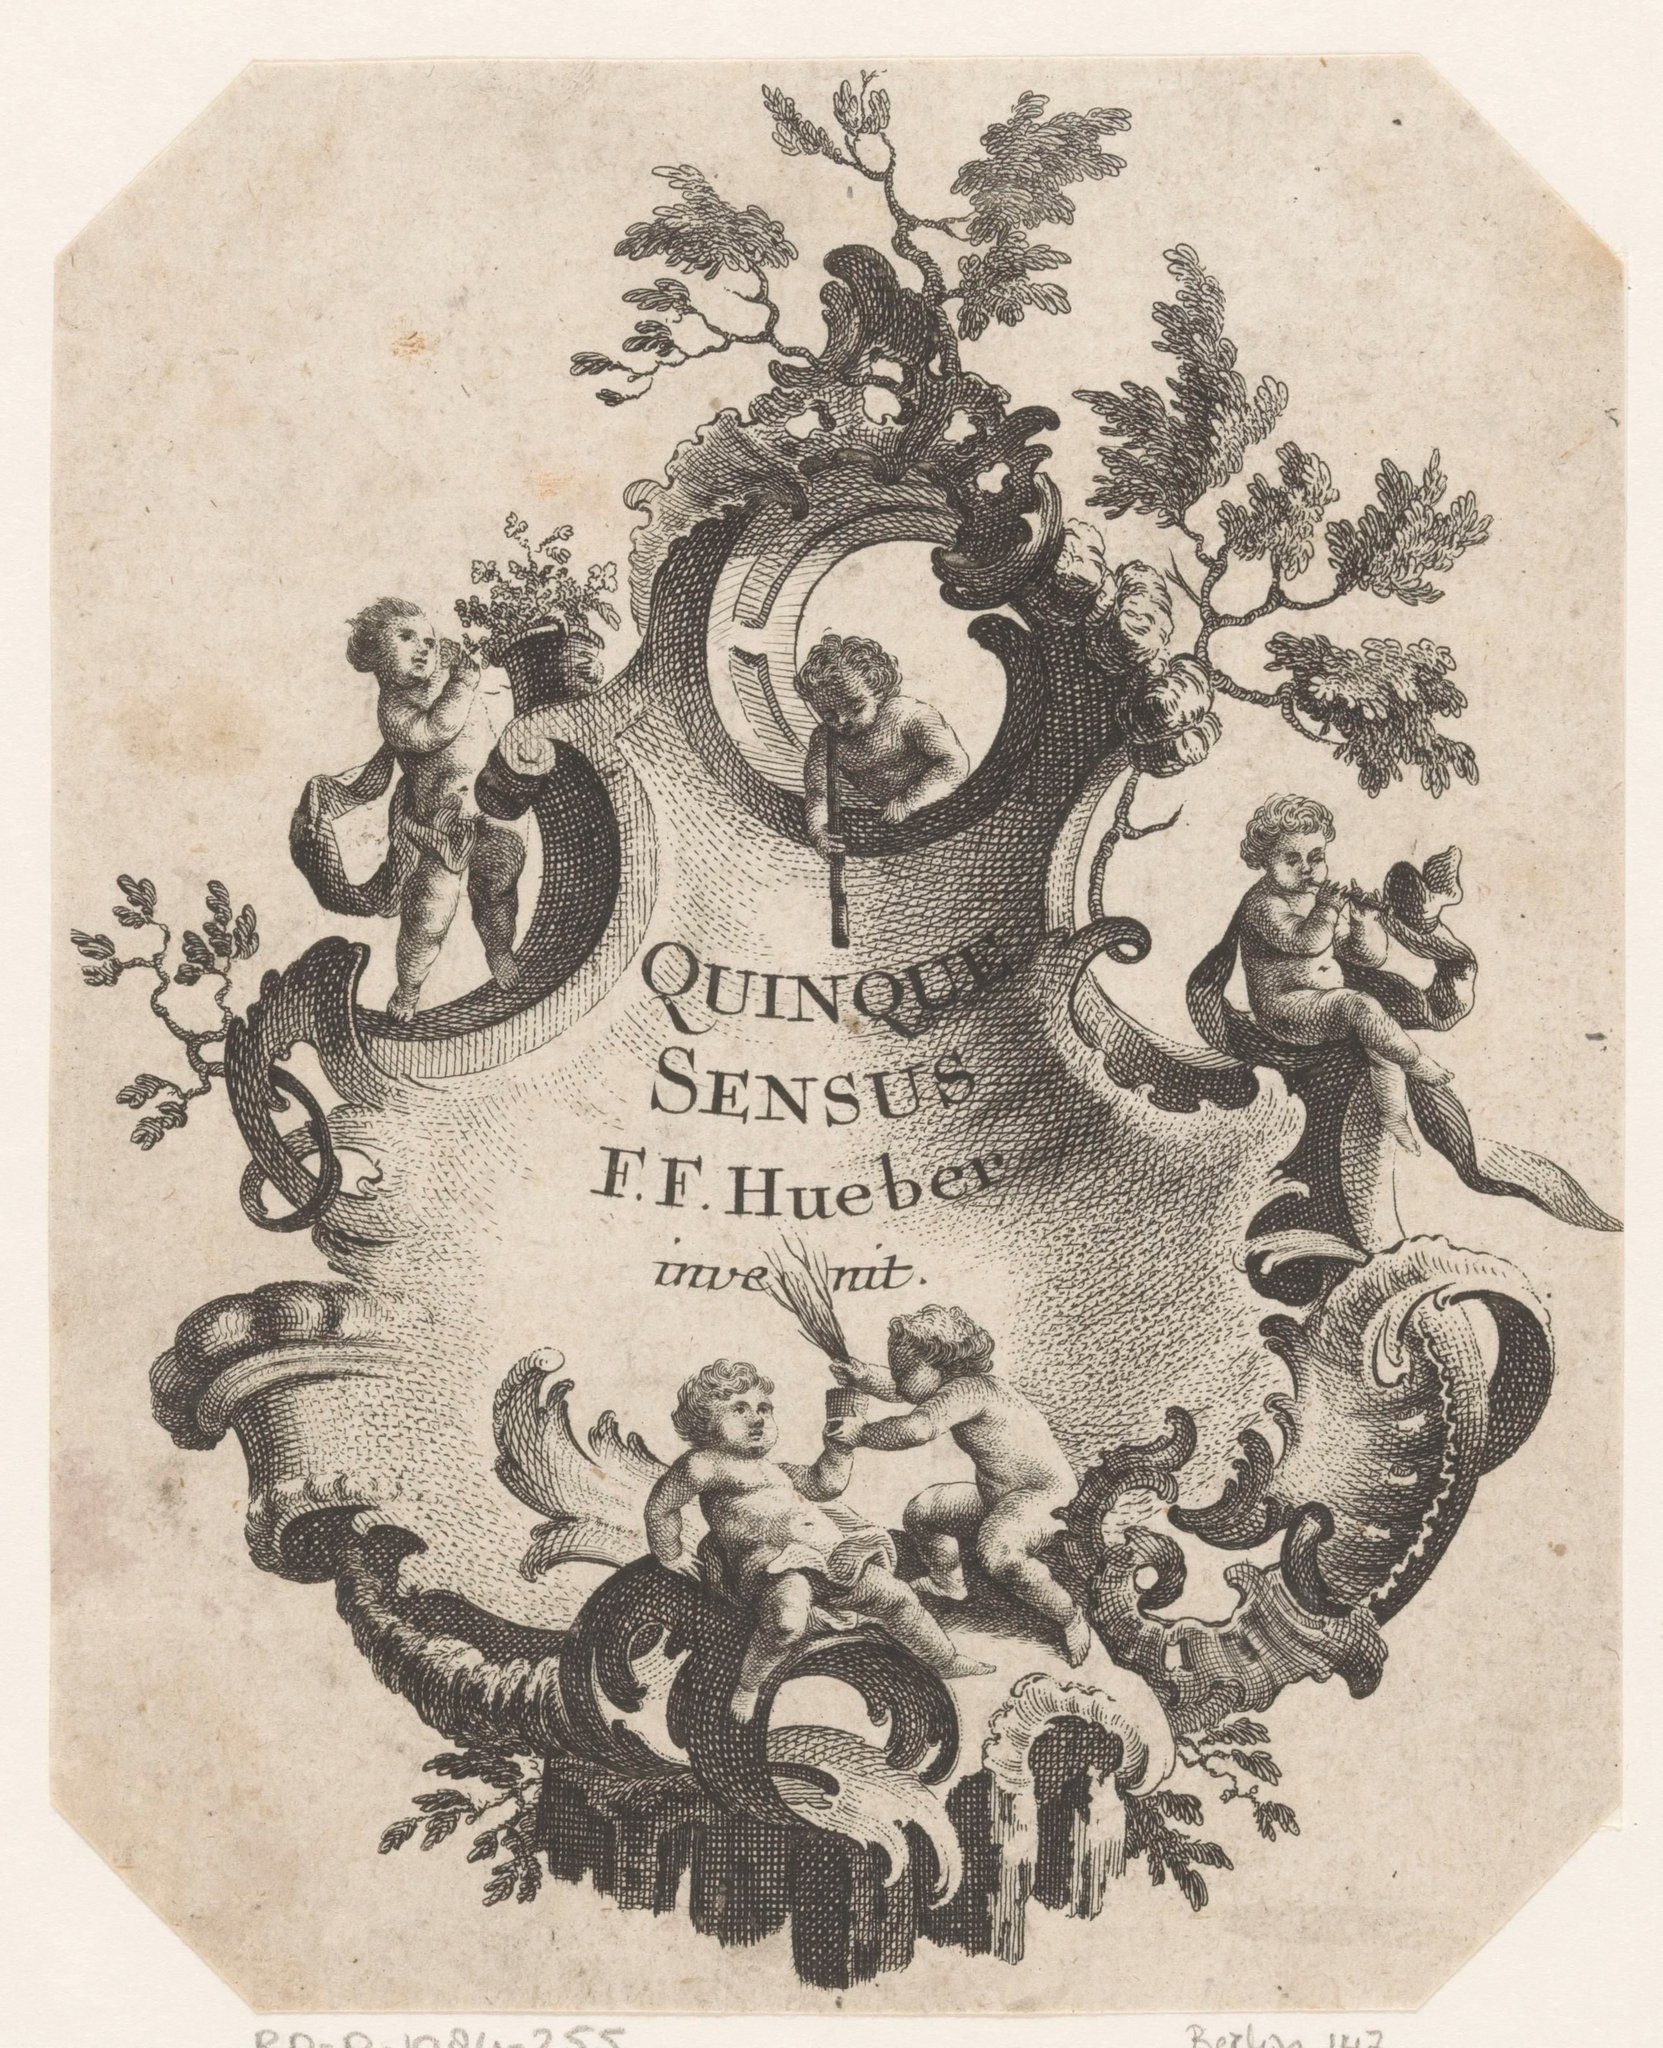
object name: print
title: Cartouche met putti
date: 1750-1778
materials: paper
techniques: etching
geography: augsburg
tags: the (five) senses, ornament ~ cartouche, cupids: 'amores', 'amoretti', 'putti'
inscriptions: collector's mark: Lugt 2228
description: Rocaille cartouche met serietitel. Rondom personificeren putti de vijf zintuigen.